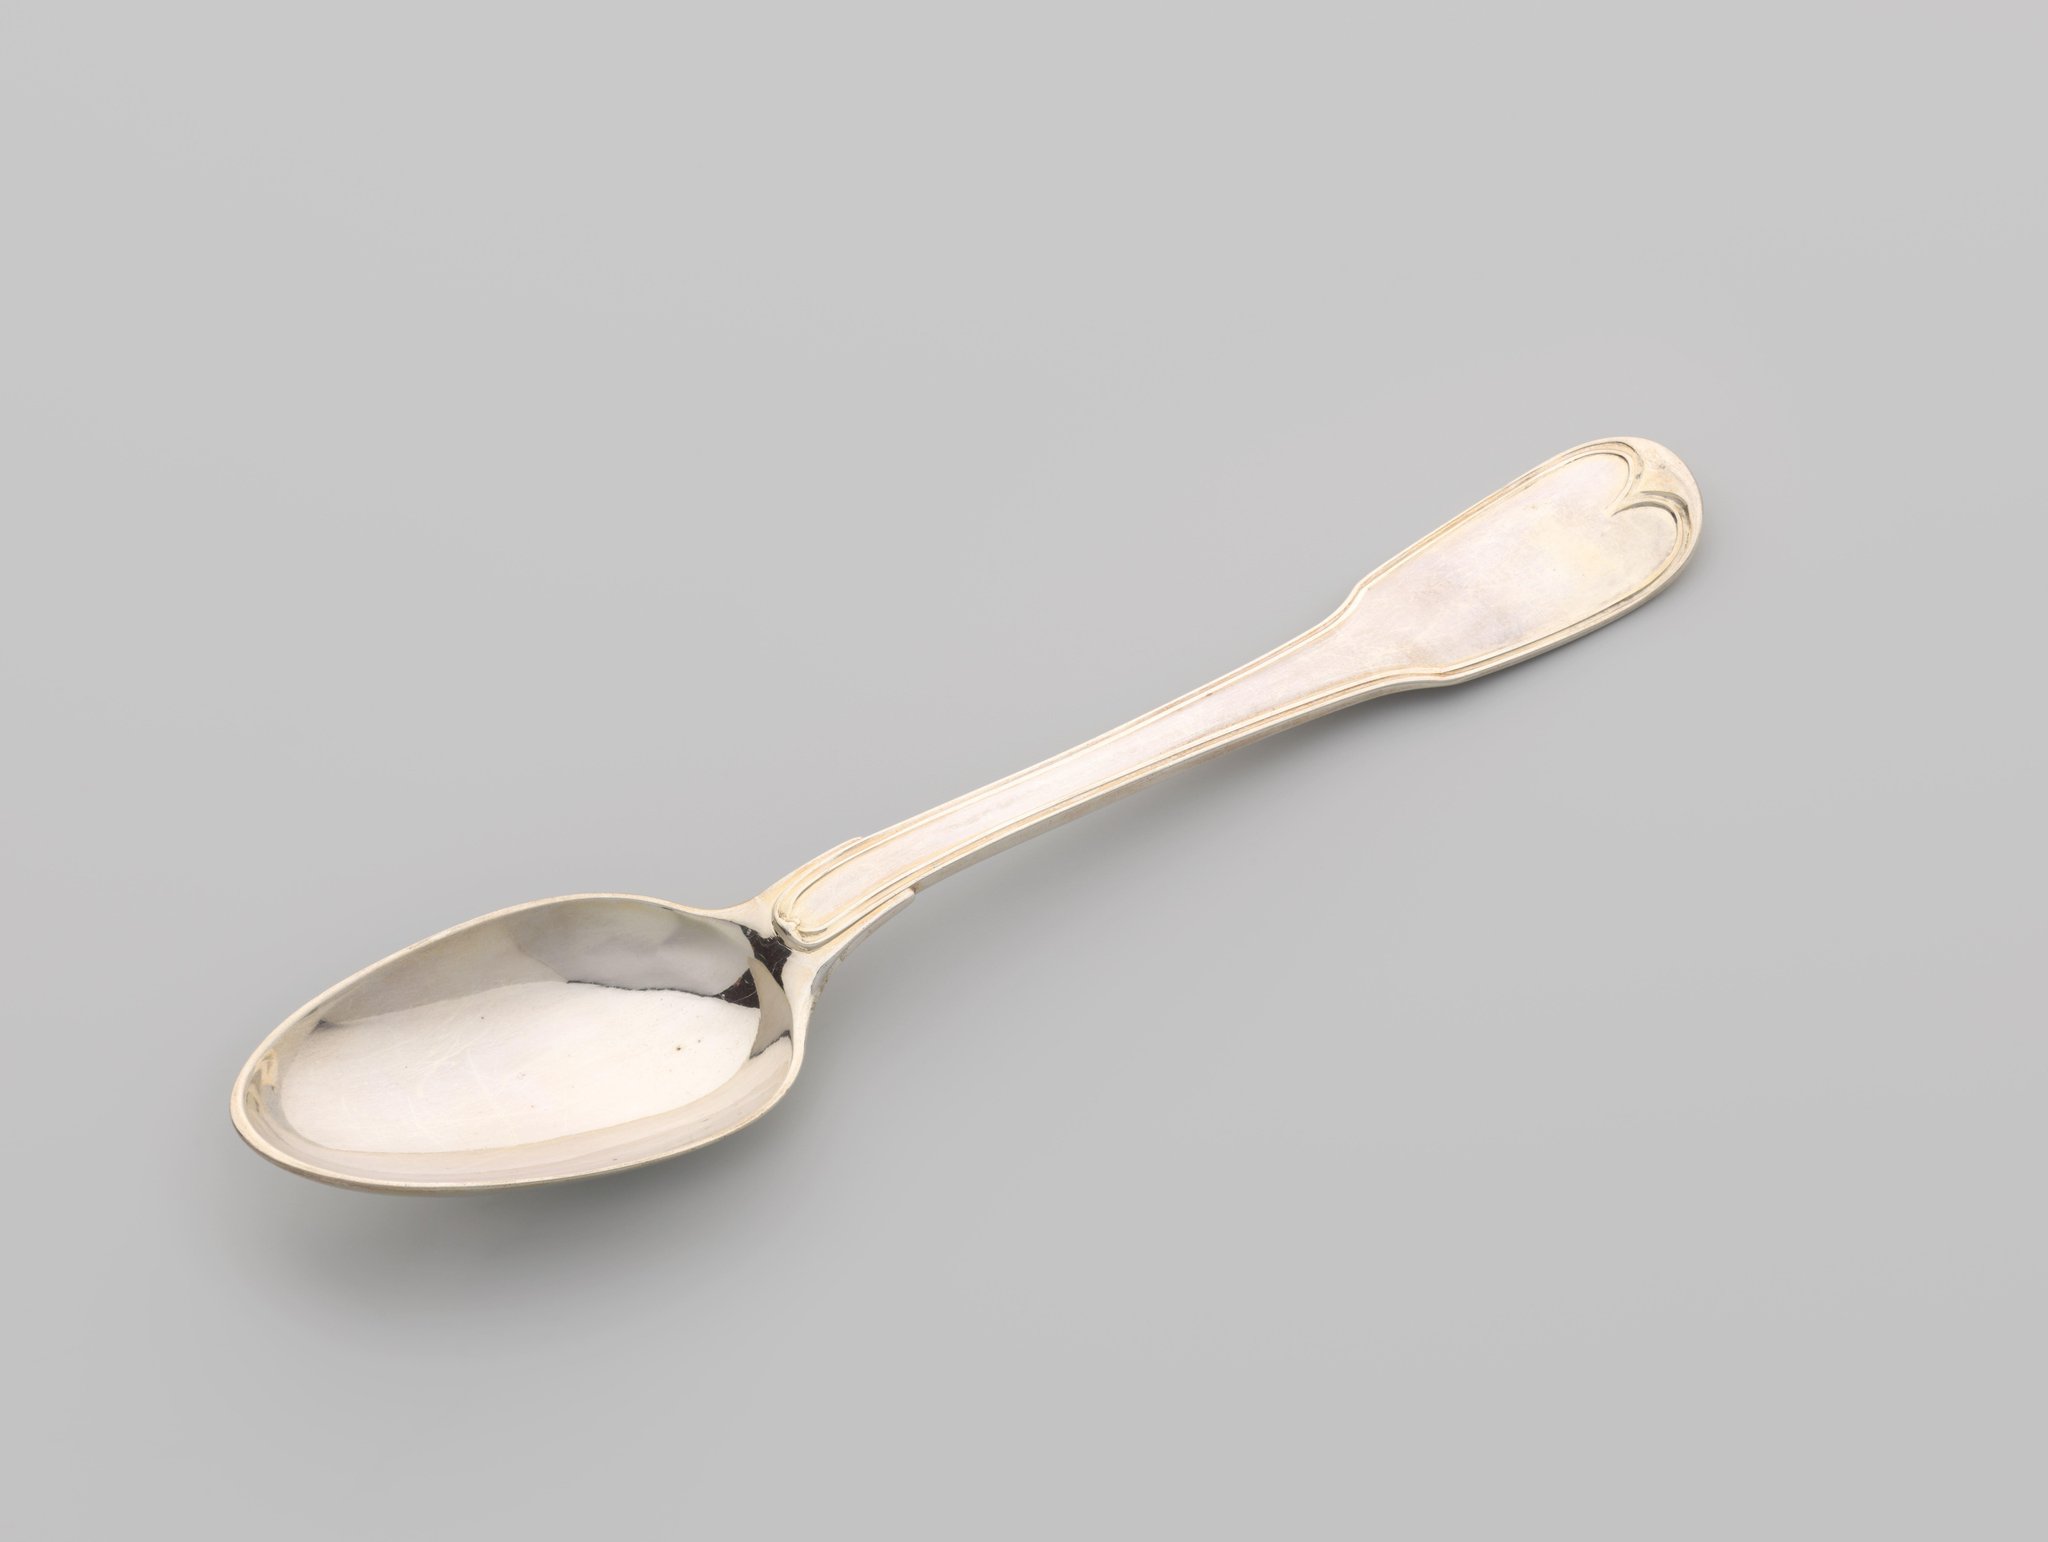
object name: spoon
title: Dessertlepel met het helmteken Clifford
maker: roelof helweg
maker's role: silversmith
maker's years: 1758-1843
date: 1806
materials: silver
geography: amsterdam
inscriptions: town mark: ‘Amsterdam’, date letter: ‘X (=1806)’, alloy mark: ‘Hollandse leeuw’, maker's mark: ‘RH in ovaal’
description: De eivormige bak van de lepel heeft een versmald uiteinde en is aan zowel boven- als onderzijde door middel van enkel lof verbonden met de platte, gebogen steel, die zich verbreedt naar het spatelvormige uiteinde. Boven- en onderzijde van de steel worden omgeven door een dubbele filetrand, die bij het uiteinde ingezwenkt is. Op de onderzijde van de spatel van zowel de lepels als de vorken is het helmteken Clifford gegraveerd.